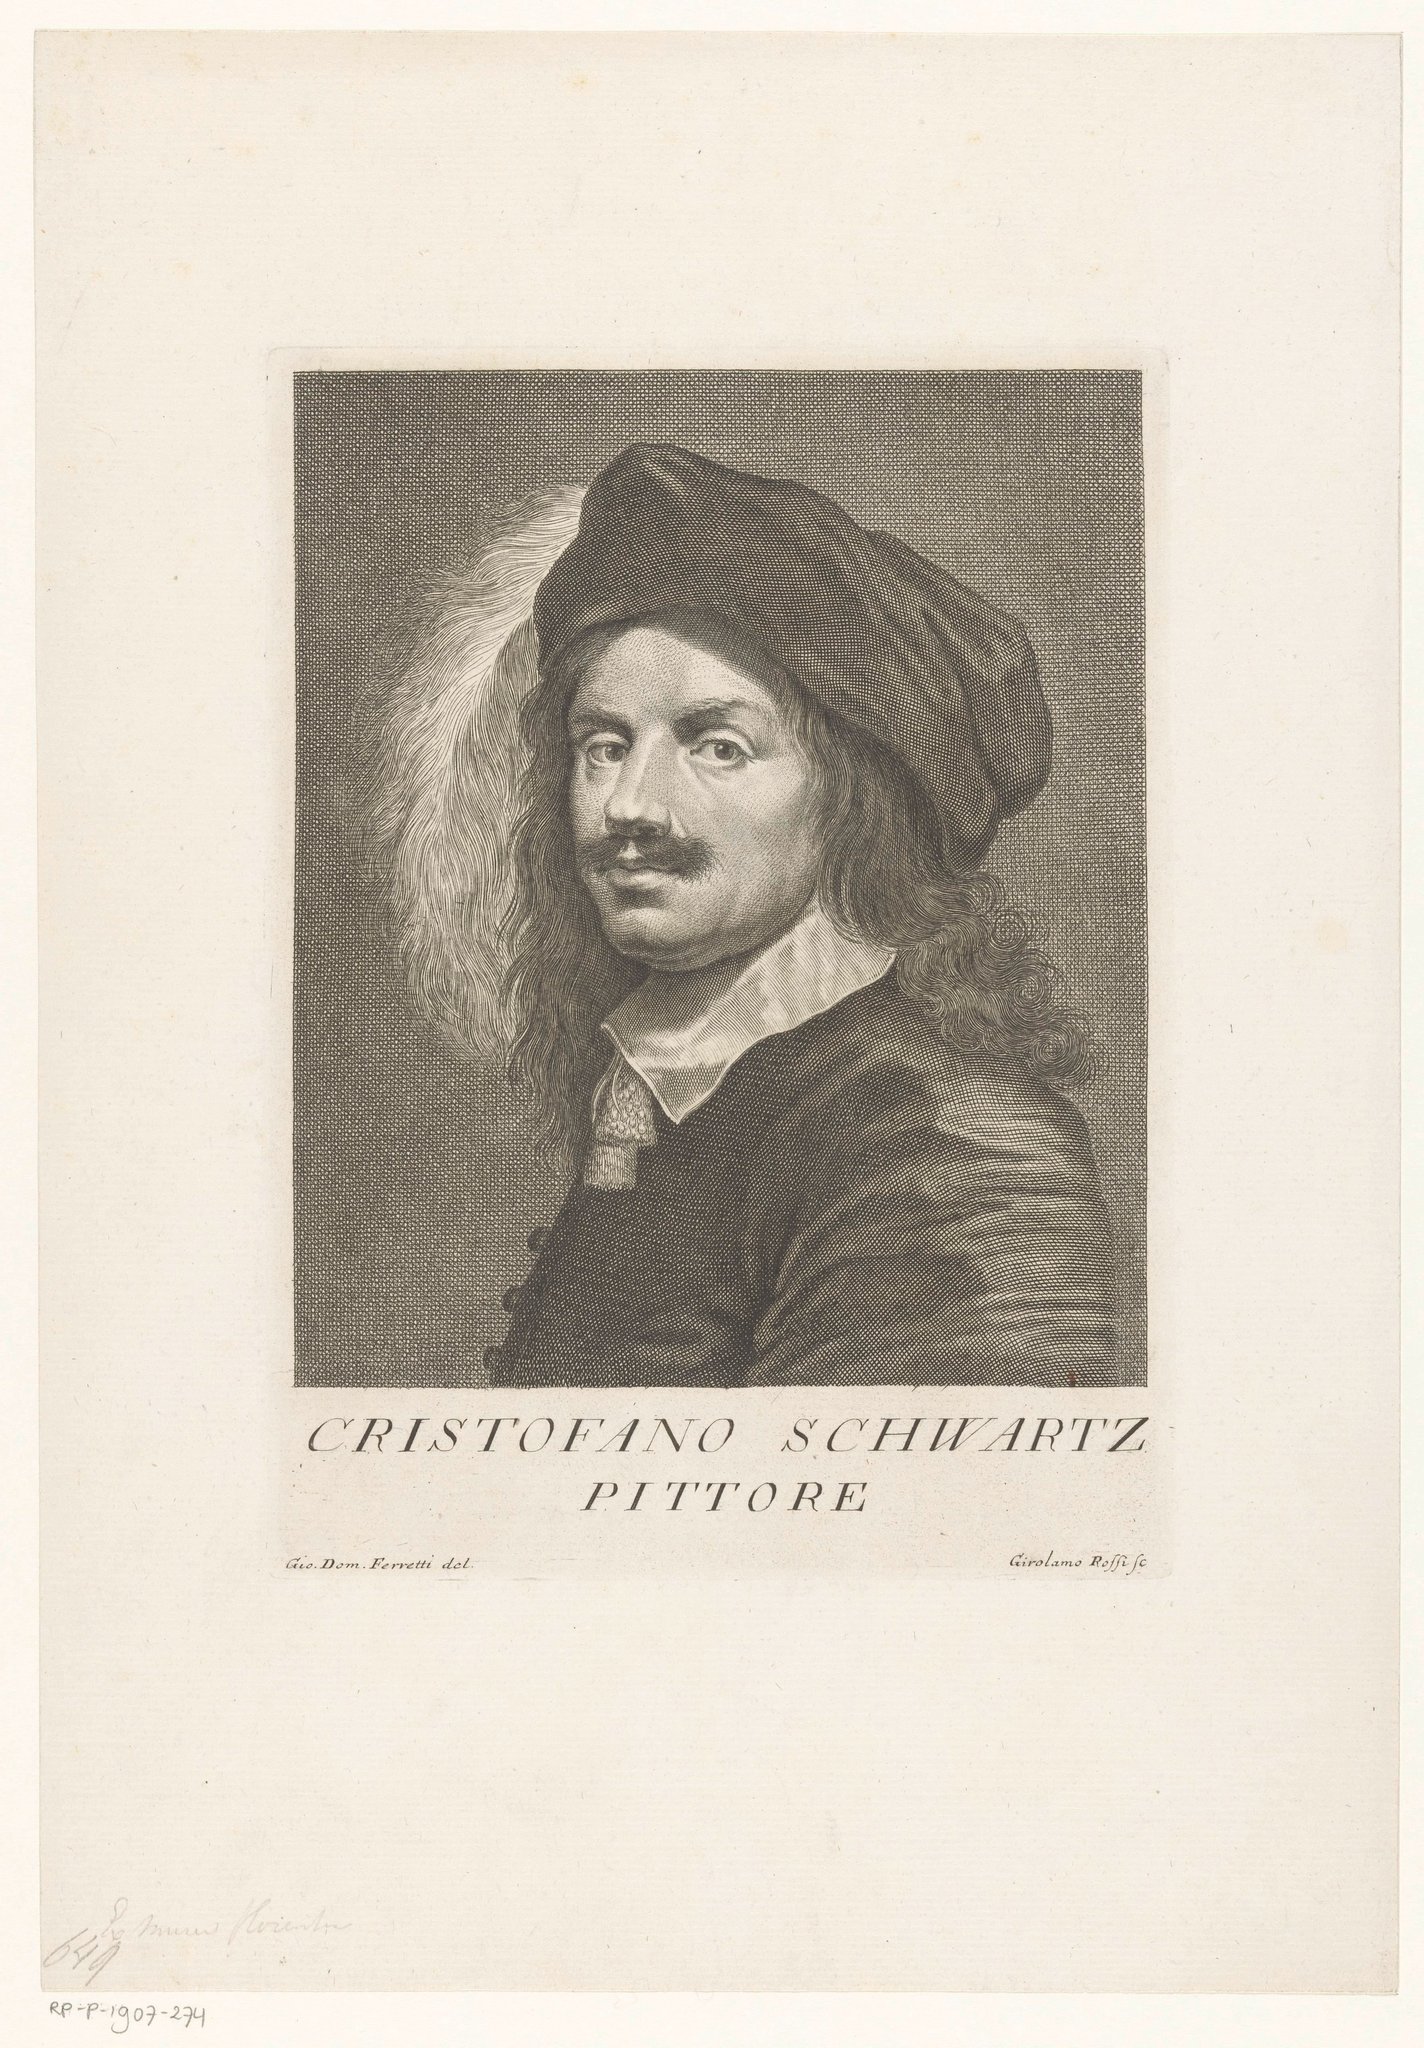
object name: book illustration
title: Cristofano Schwartz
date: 1752-1762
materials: paper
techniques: etching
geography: italy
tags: brussels, painter, print maker, michael sweerts, historical persons, portrait, self-portrait of artist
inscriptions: collector's mark: Lugt 2228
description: Prent uit: Moücke, Francesco. Serie di ritratti degli eccellenti pittori dipinti di propria mano, che esistono nell'Imiperial Galleria di Firenze. Florence: 1752-1762.